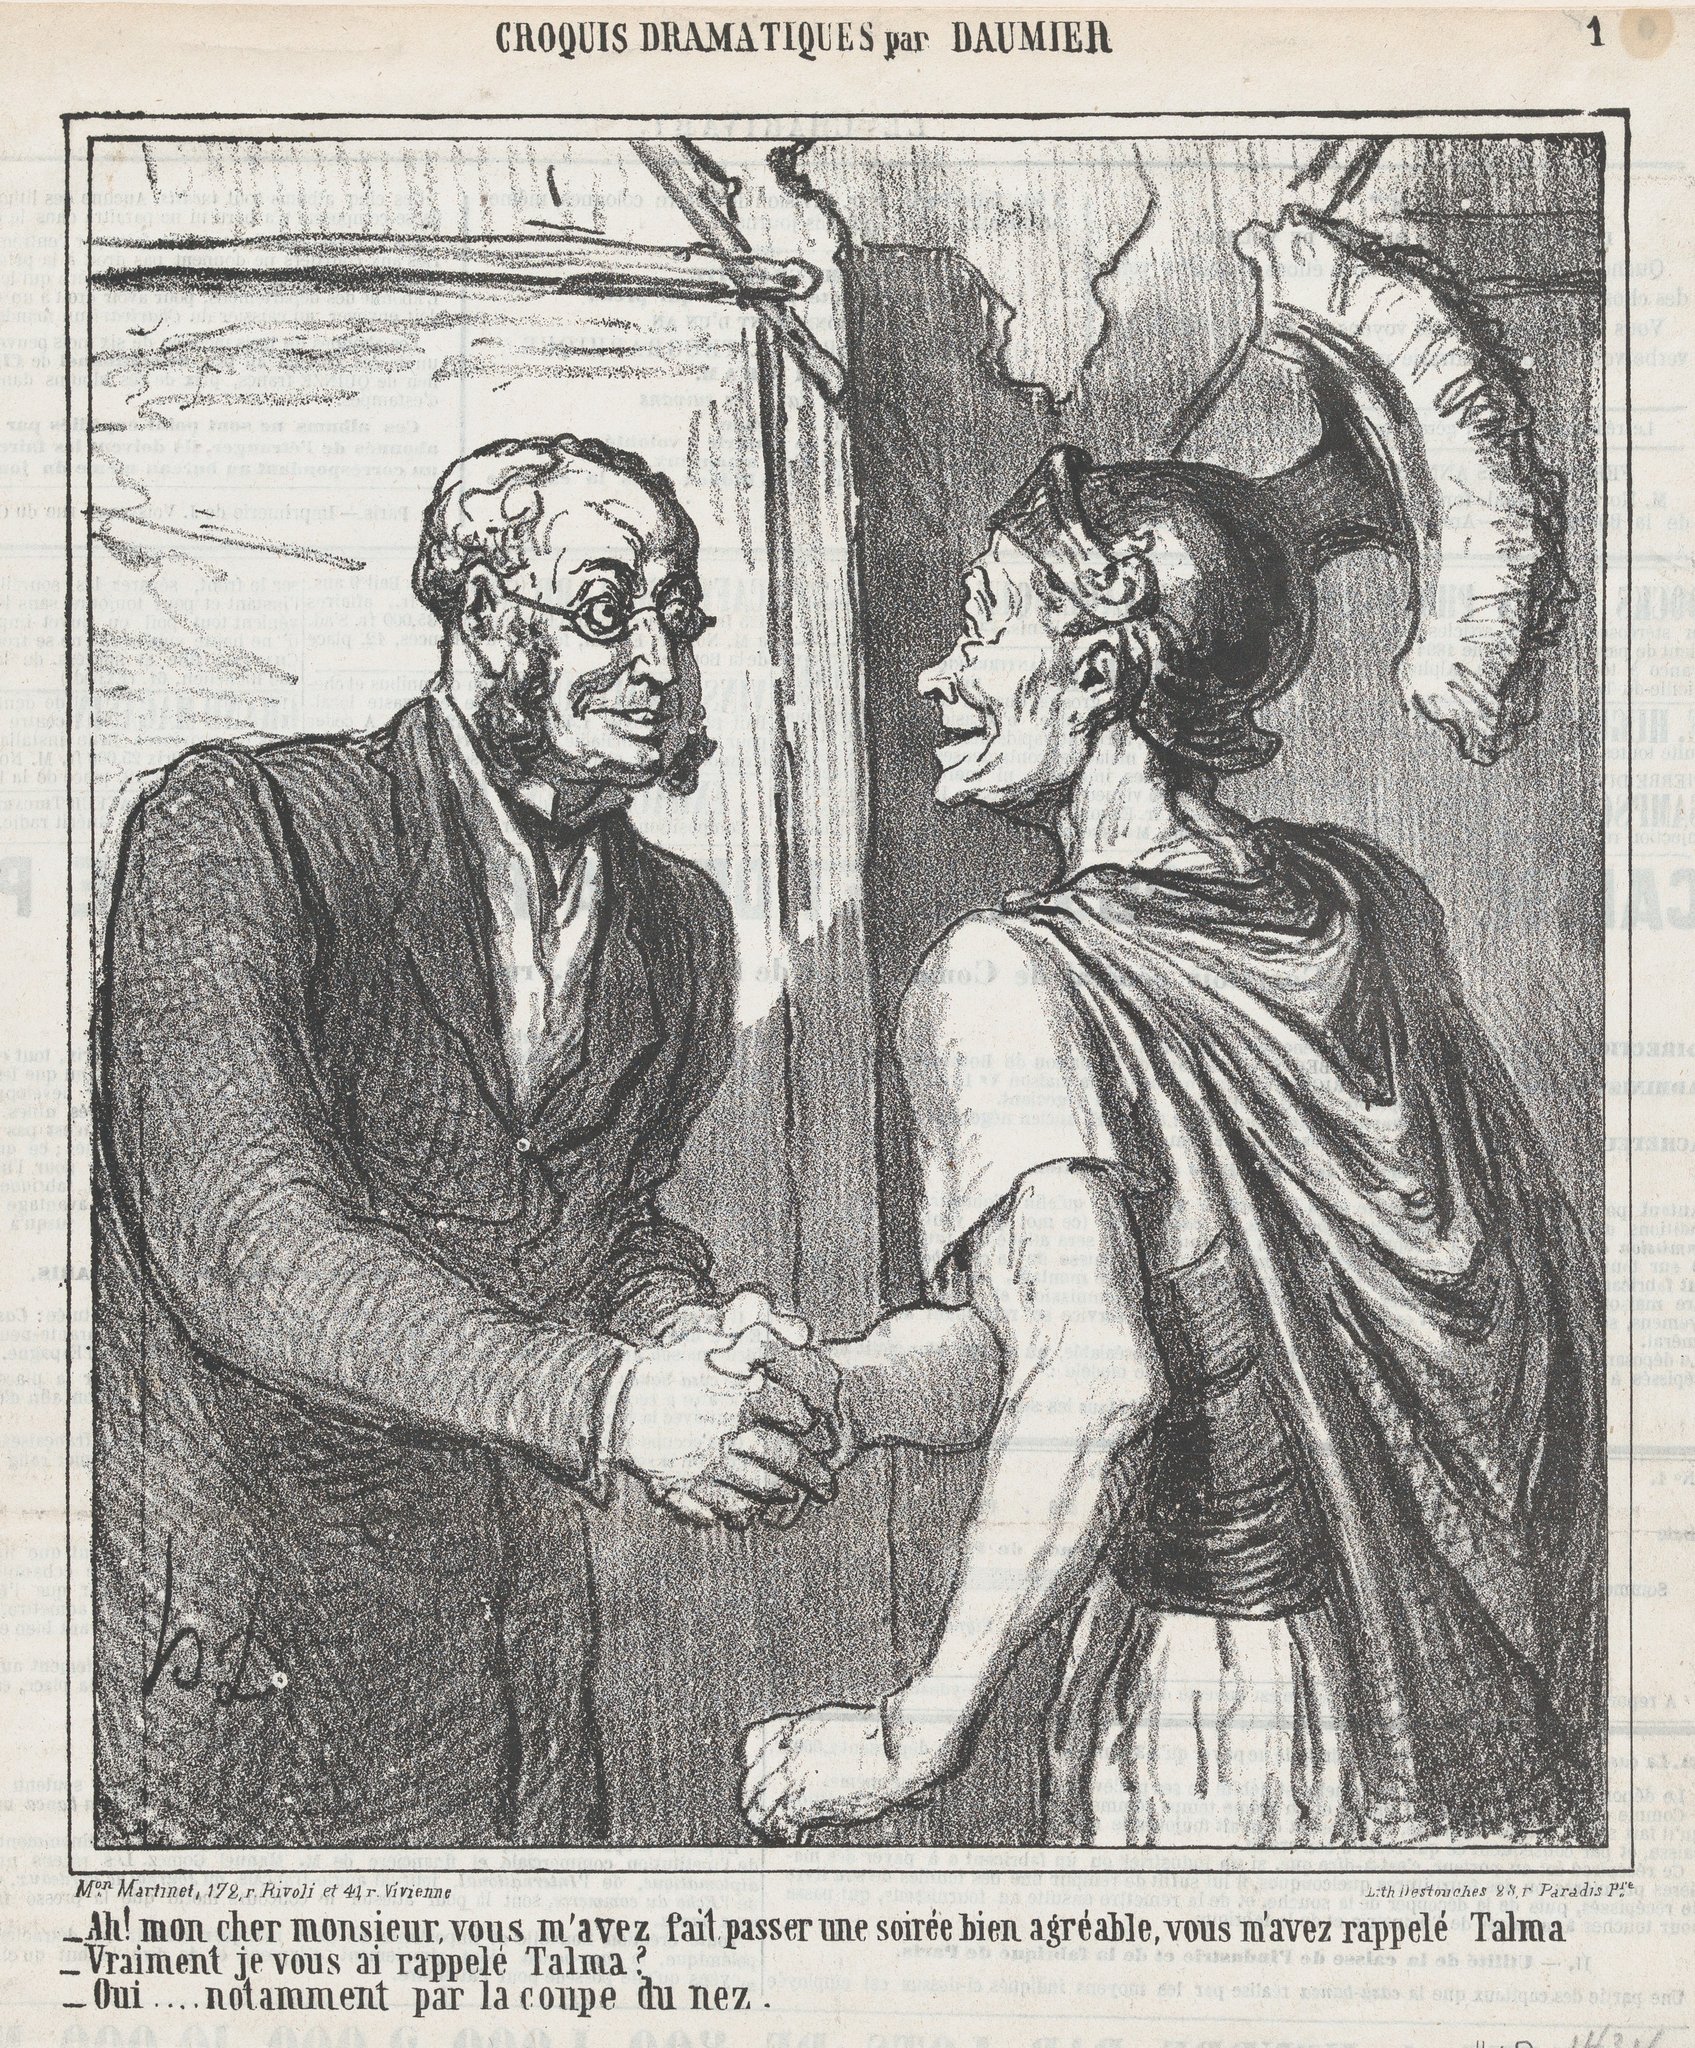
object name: print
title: Ah, my dear sir, you have made my evening a very pleasant one..., from "Dramatic Sketches"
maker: honoré daumier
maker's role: artist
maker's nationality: french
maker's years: 1808-1879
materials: paper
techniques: lithograph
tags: men